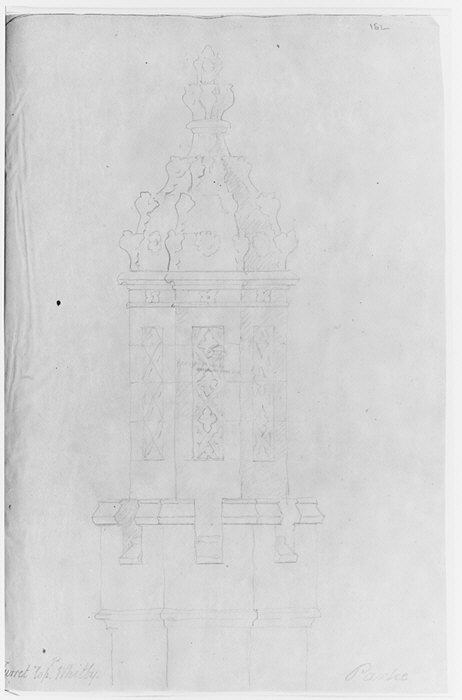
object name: drawing ornament architecture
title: Turret top for Whitby, William P. Chapman House, Rye, New York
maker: alexander jackson davis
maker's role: artist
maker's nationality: american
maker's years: 1803-1892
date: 1853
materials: graphite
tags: buildings